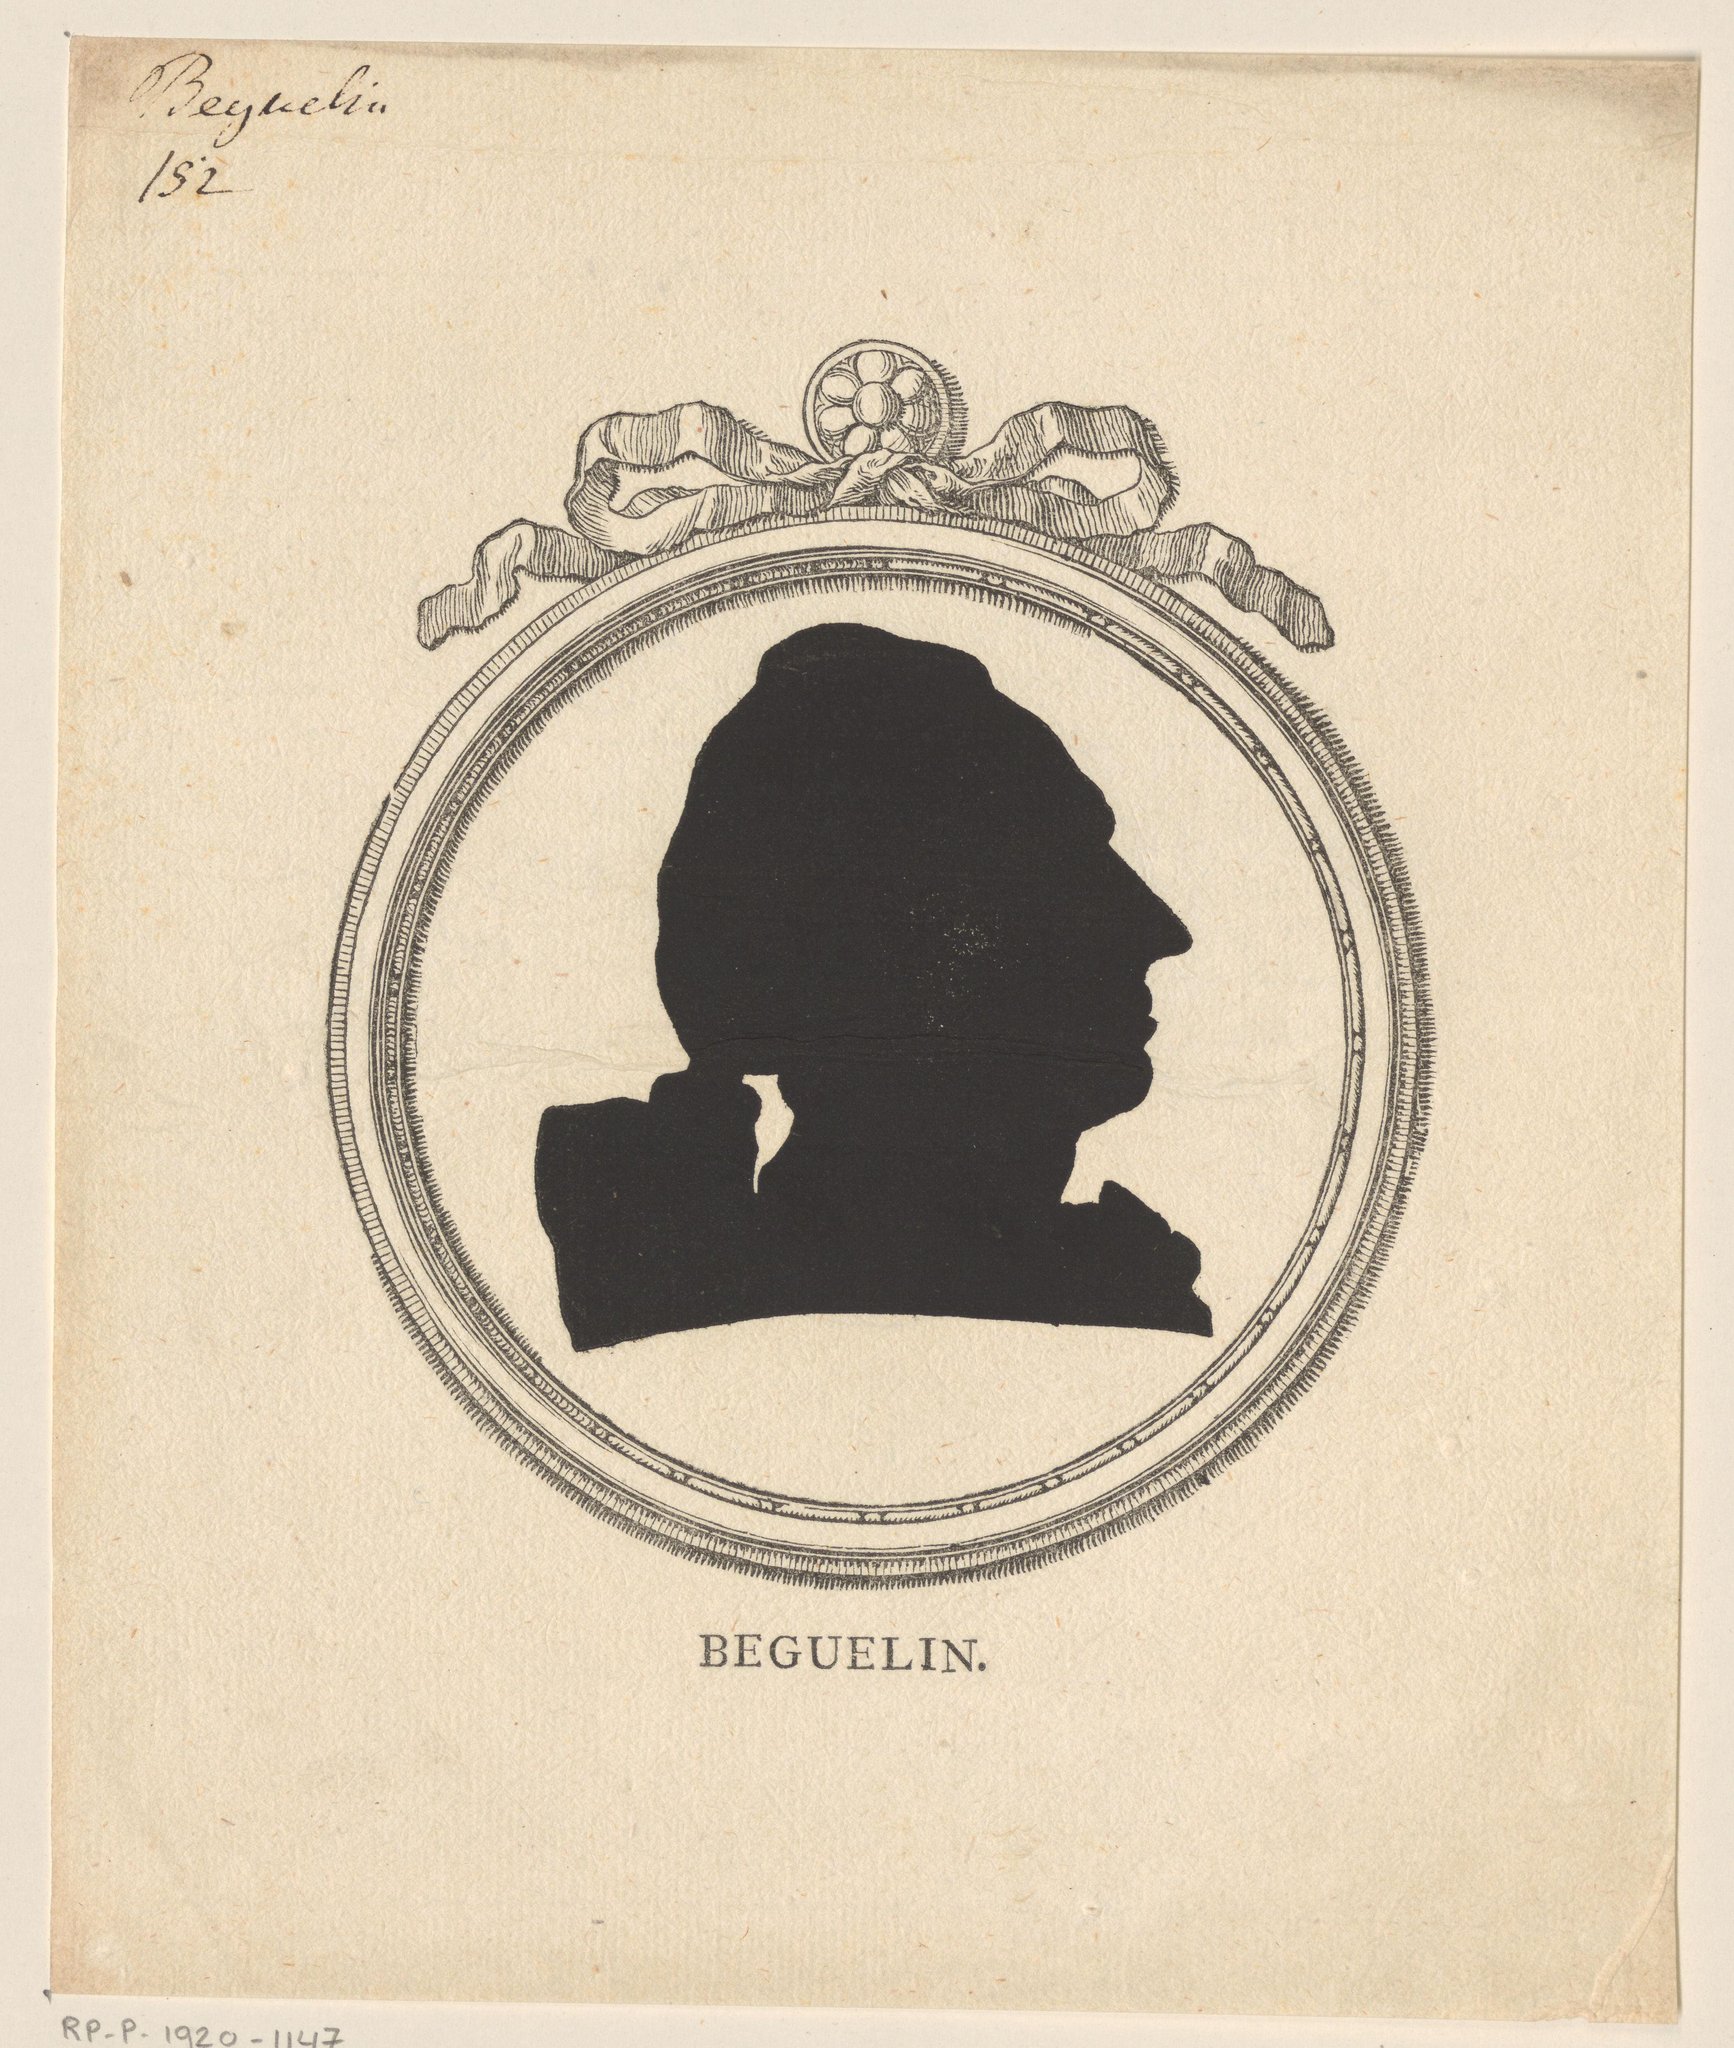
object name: print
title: Silhouetportret van Nicolaus von Béguelin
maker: johann friedrich gottlieb unger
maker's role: print maker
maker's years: 1753-1804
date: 1779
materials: paper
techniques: letterpress printing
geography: berlin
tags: historical persons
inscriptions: collector's mark: Lugt 2228